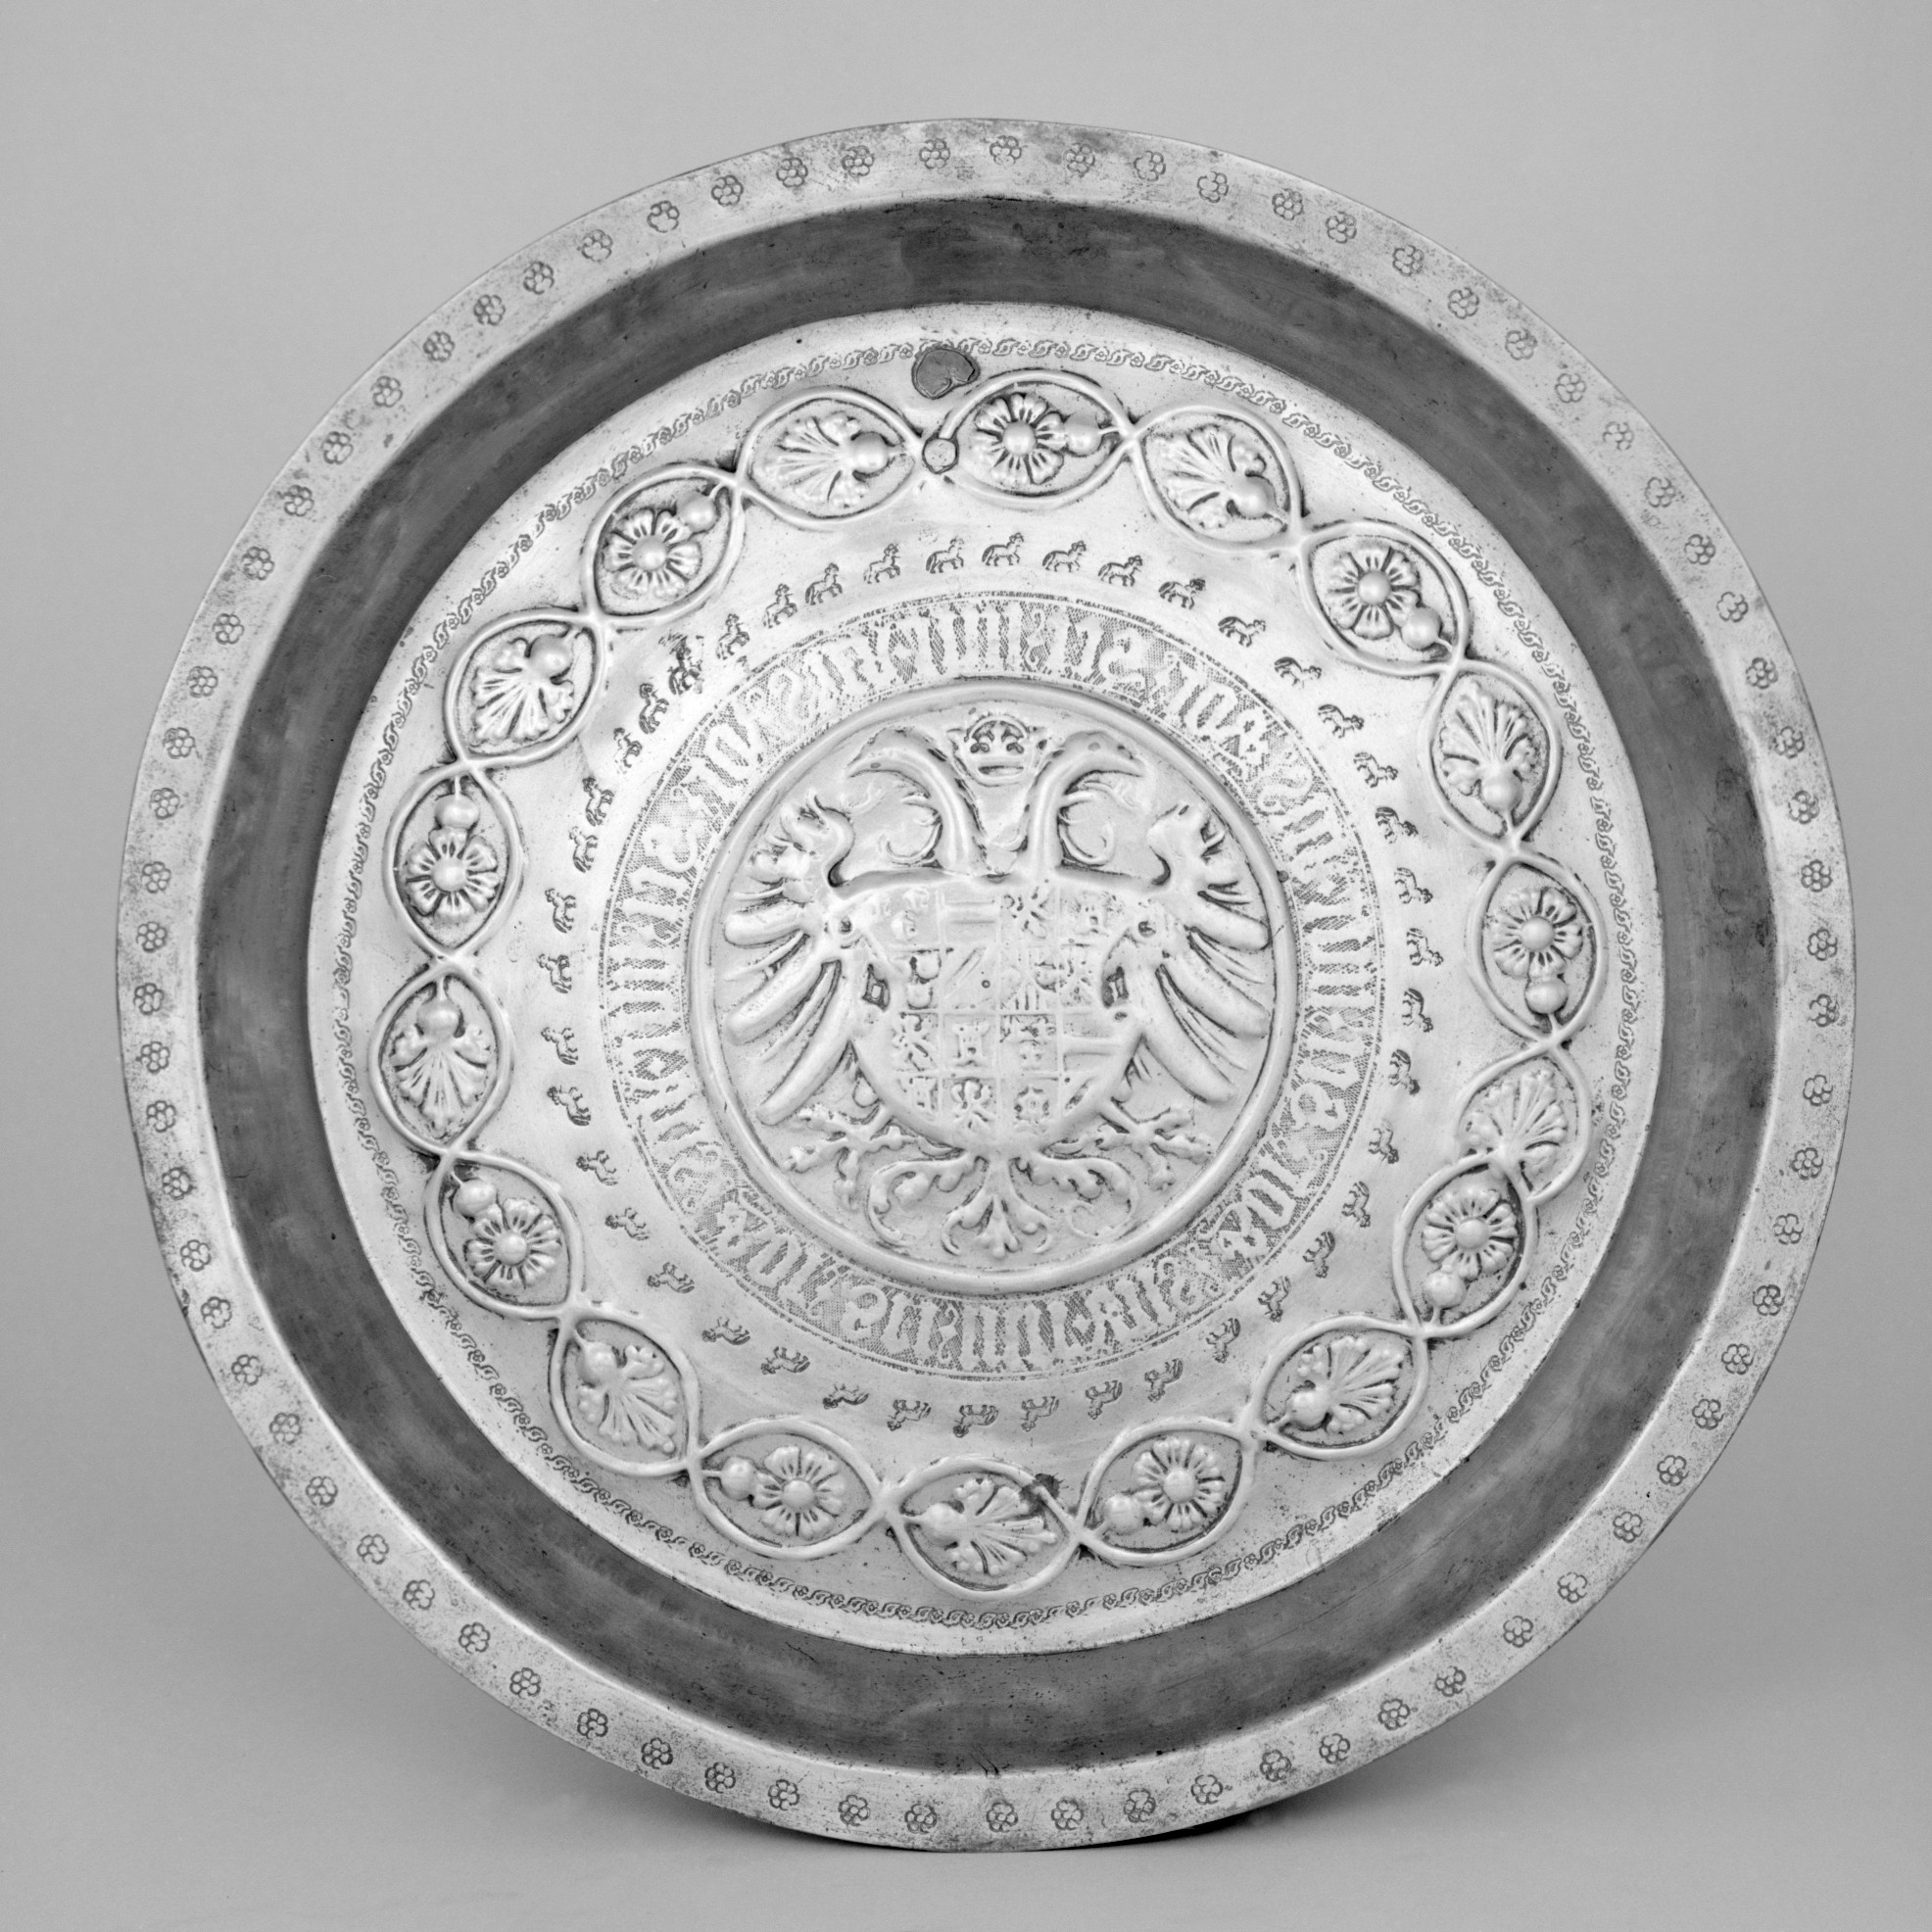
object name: plate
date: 1520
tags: flowers,coat of arms